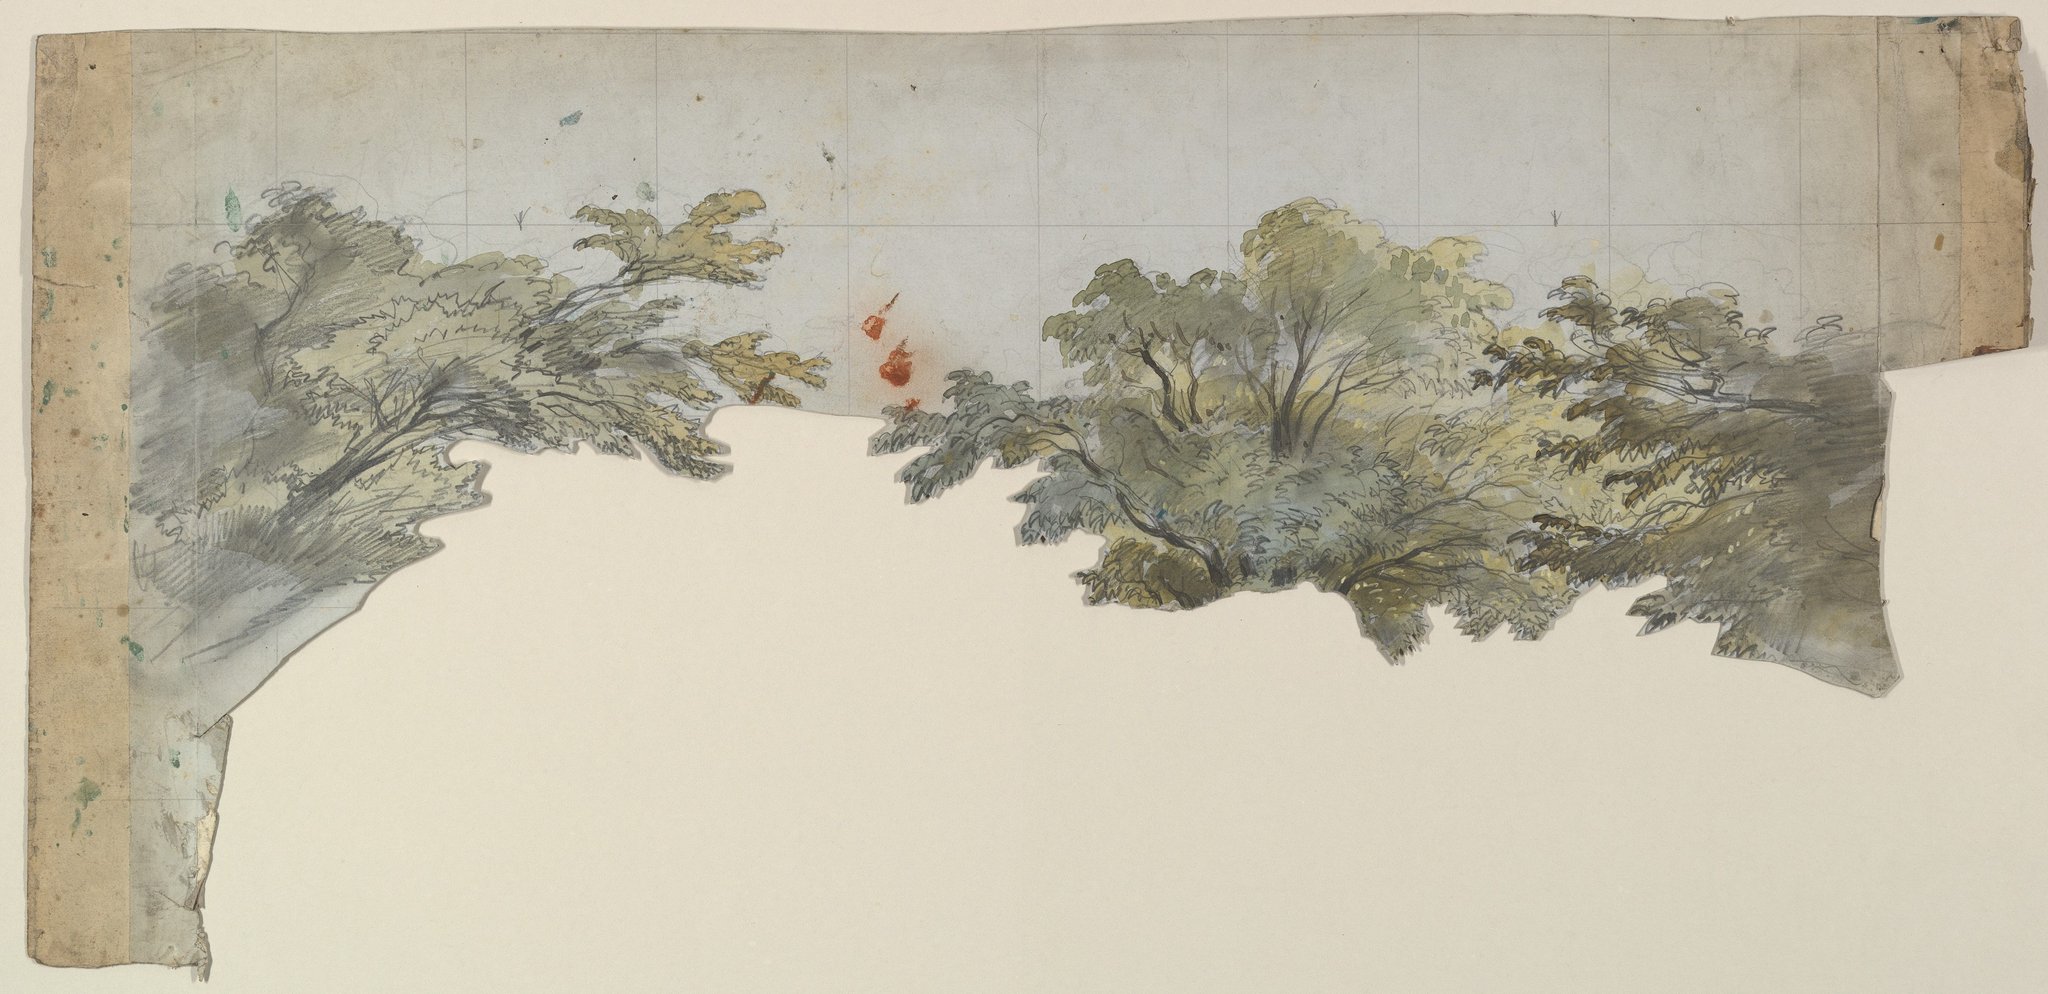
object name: drawing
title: Design for a Stage Set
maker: eugène cicéri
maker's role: artist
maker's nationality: french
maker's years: 1813-1890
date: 1830-1890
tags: stage design